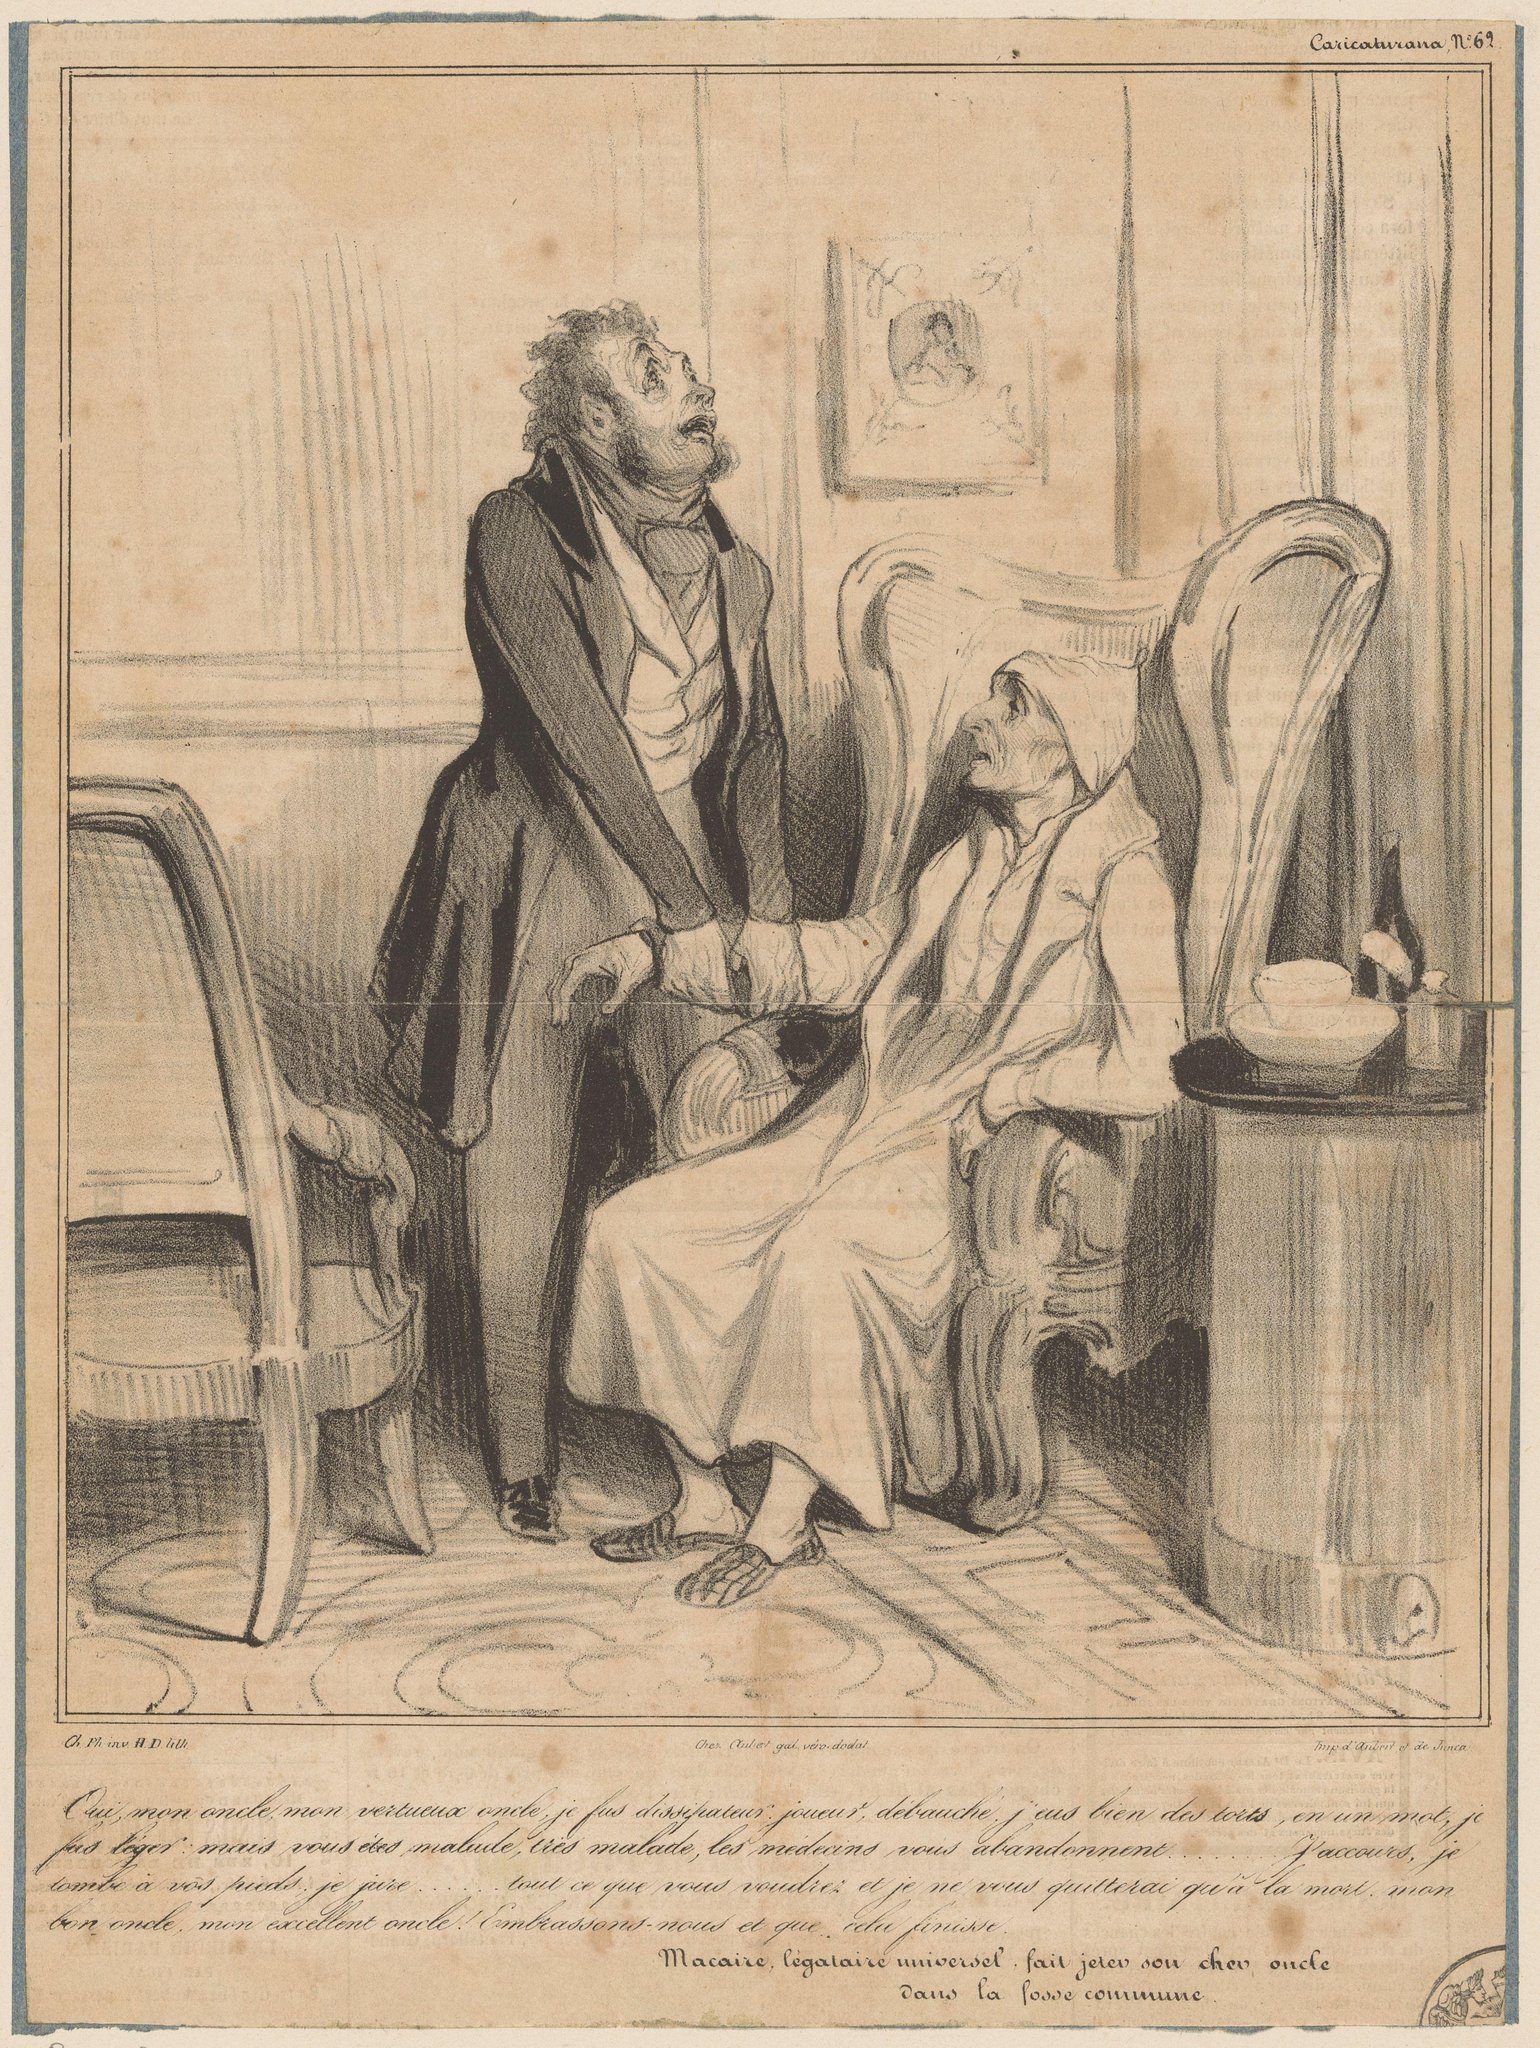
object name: cartoon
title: Robert Macaire bij zijn stervende oom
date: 1837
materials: paper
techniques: letterpress printing, lithograph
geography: paris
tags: caricatures (human types), last words and last favours, nuncupate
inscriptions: collector's mark: Lugt 2228a, stamp: ‘Timbre Royal Seine, 3 c.’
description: Robert Macaire beweert tegen zijn oom dat hij zijn leven gebeterd heeft.